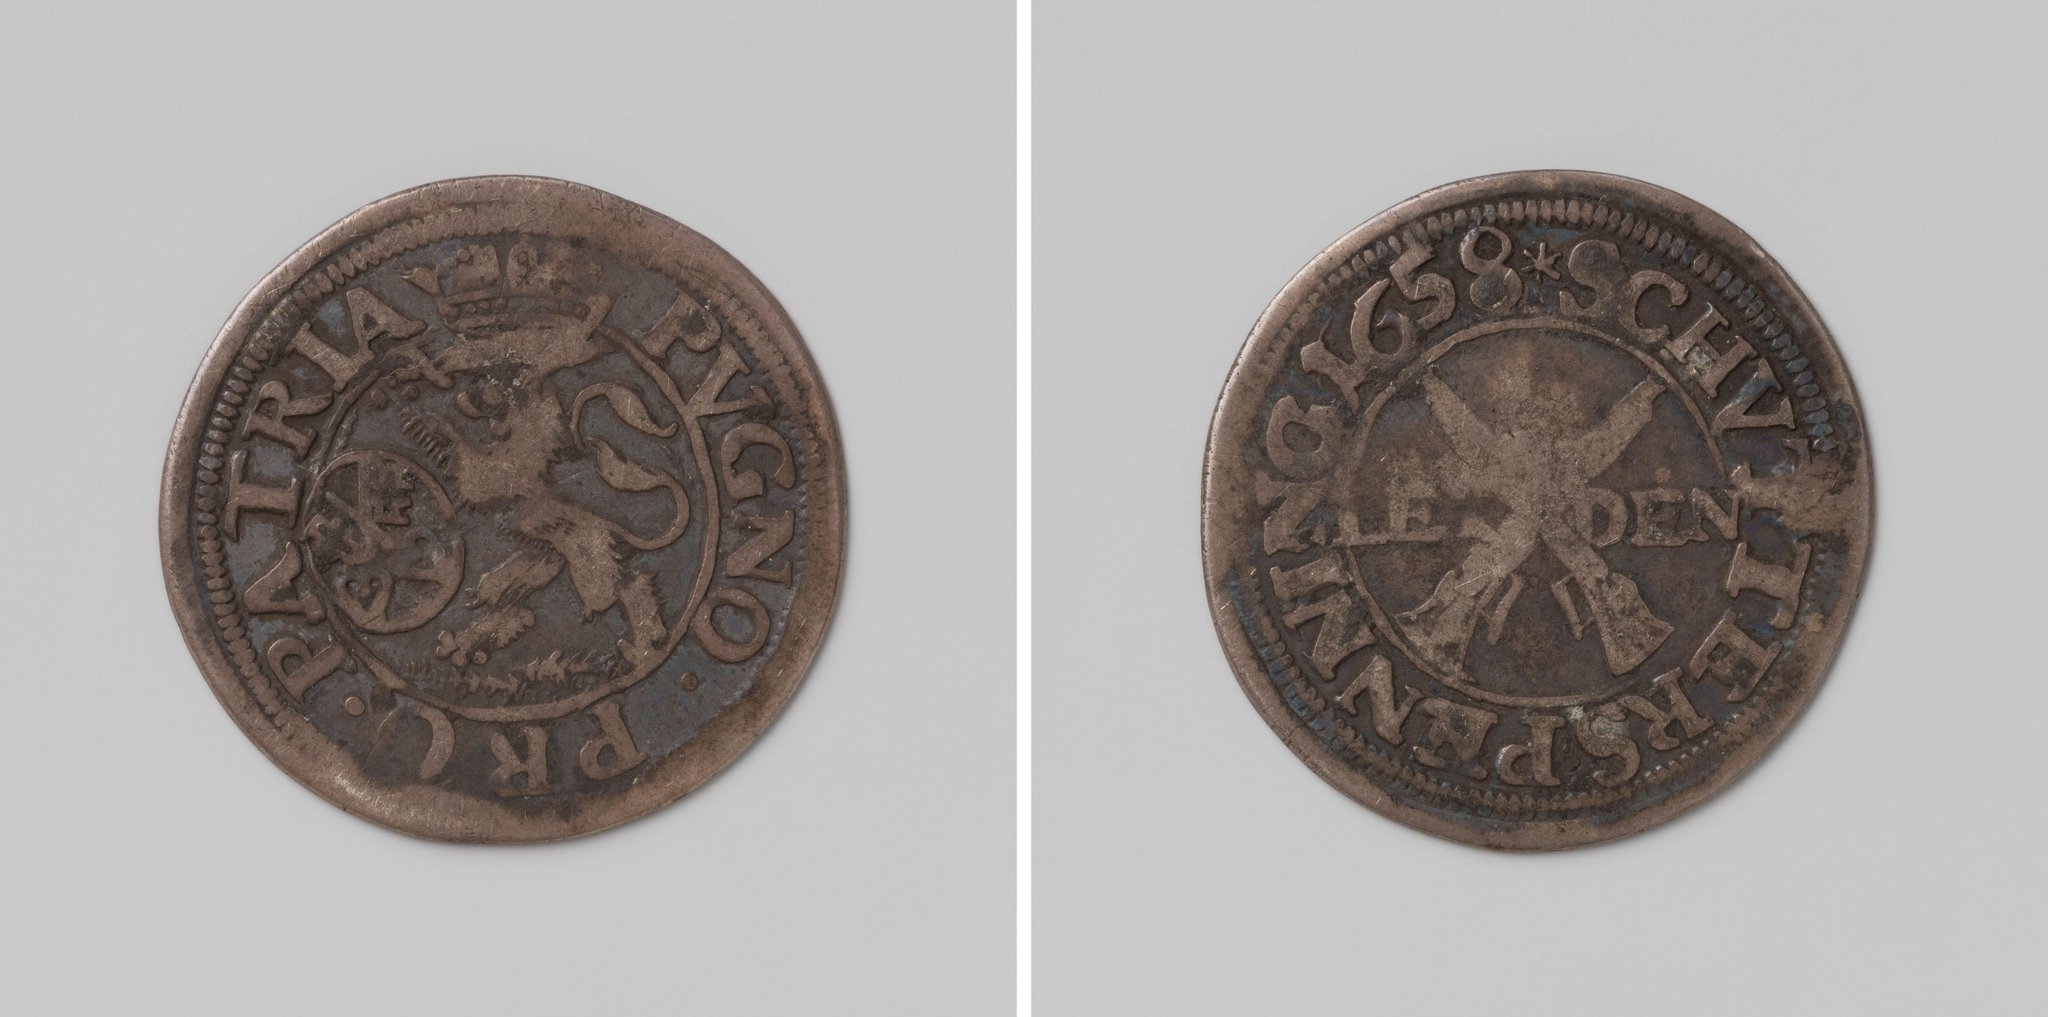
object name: marksman medal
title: Schutterij van Leiden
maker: Anonymous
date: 1658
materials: silver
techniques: striking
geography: leiden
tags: leiden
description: Zilveren penning. Voorzijde: leeuw met zwaard in boven hoofd geheven rechterklauw en schild in linkerklauw onder kroon binnen omschrift. Keerzijde: twee gekruiste musketten tussen opschrift binnen omschrift